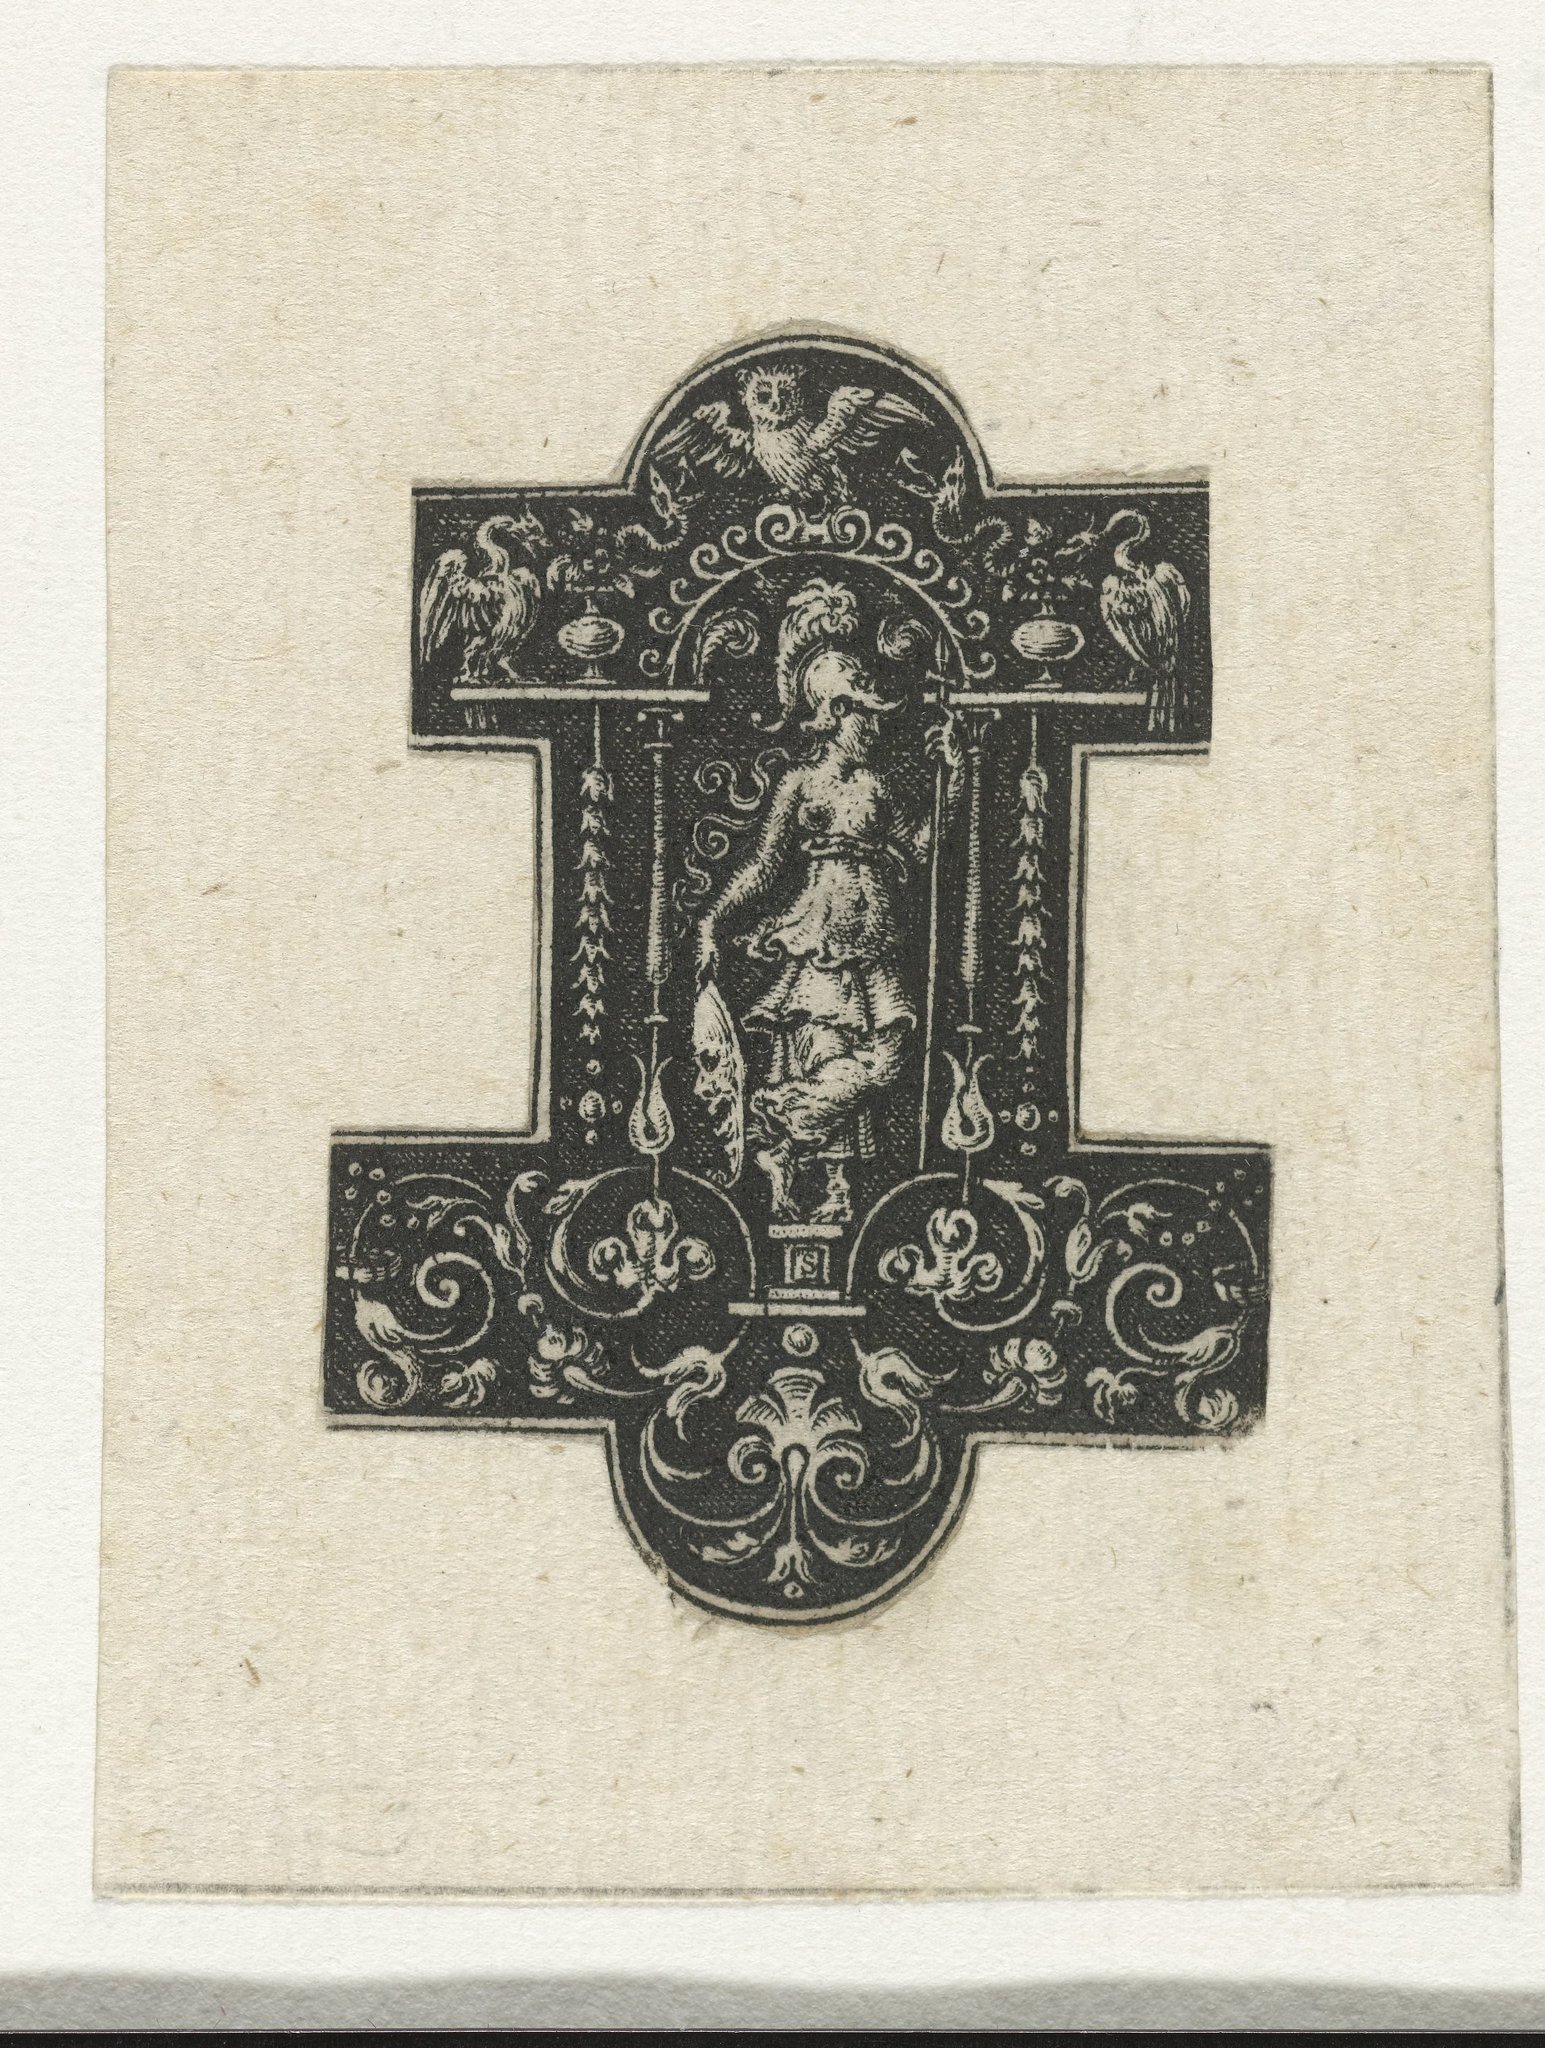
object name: ornament print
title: Verschillende kleine ornamentprenten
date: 1528-1573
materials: paper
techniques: engraving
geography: france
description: Bovenaan zit een uil. Uit serie van 7 bladen met ornamenten in de vorm van een Lotharings kruis met een korte, ronde boven- en onderkant.